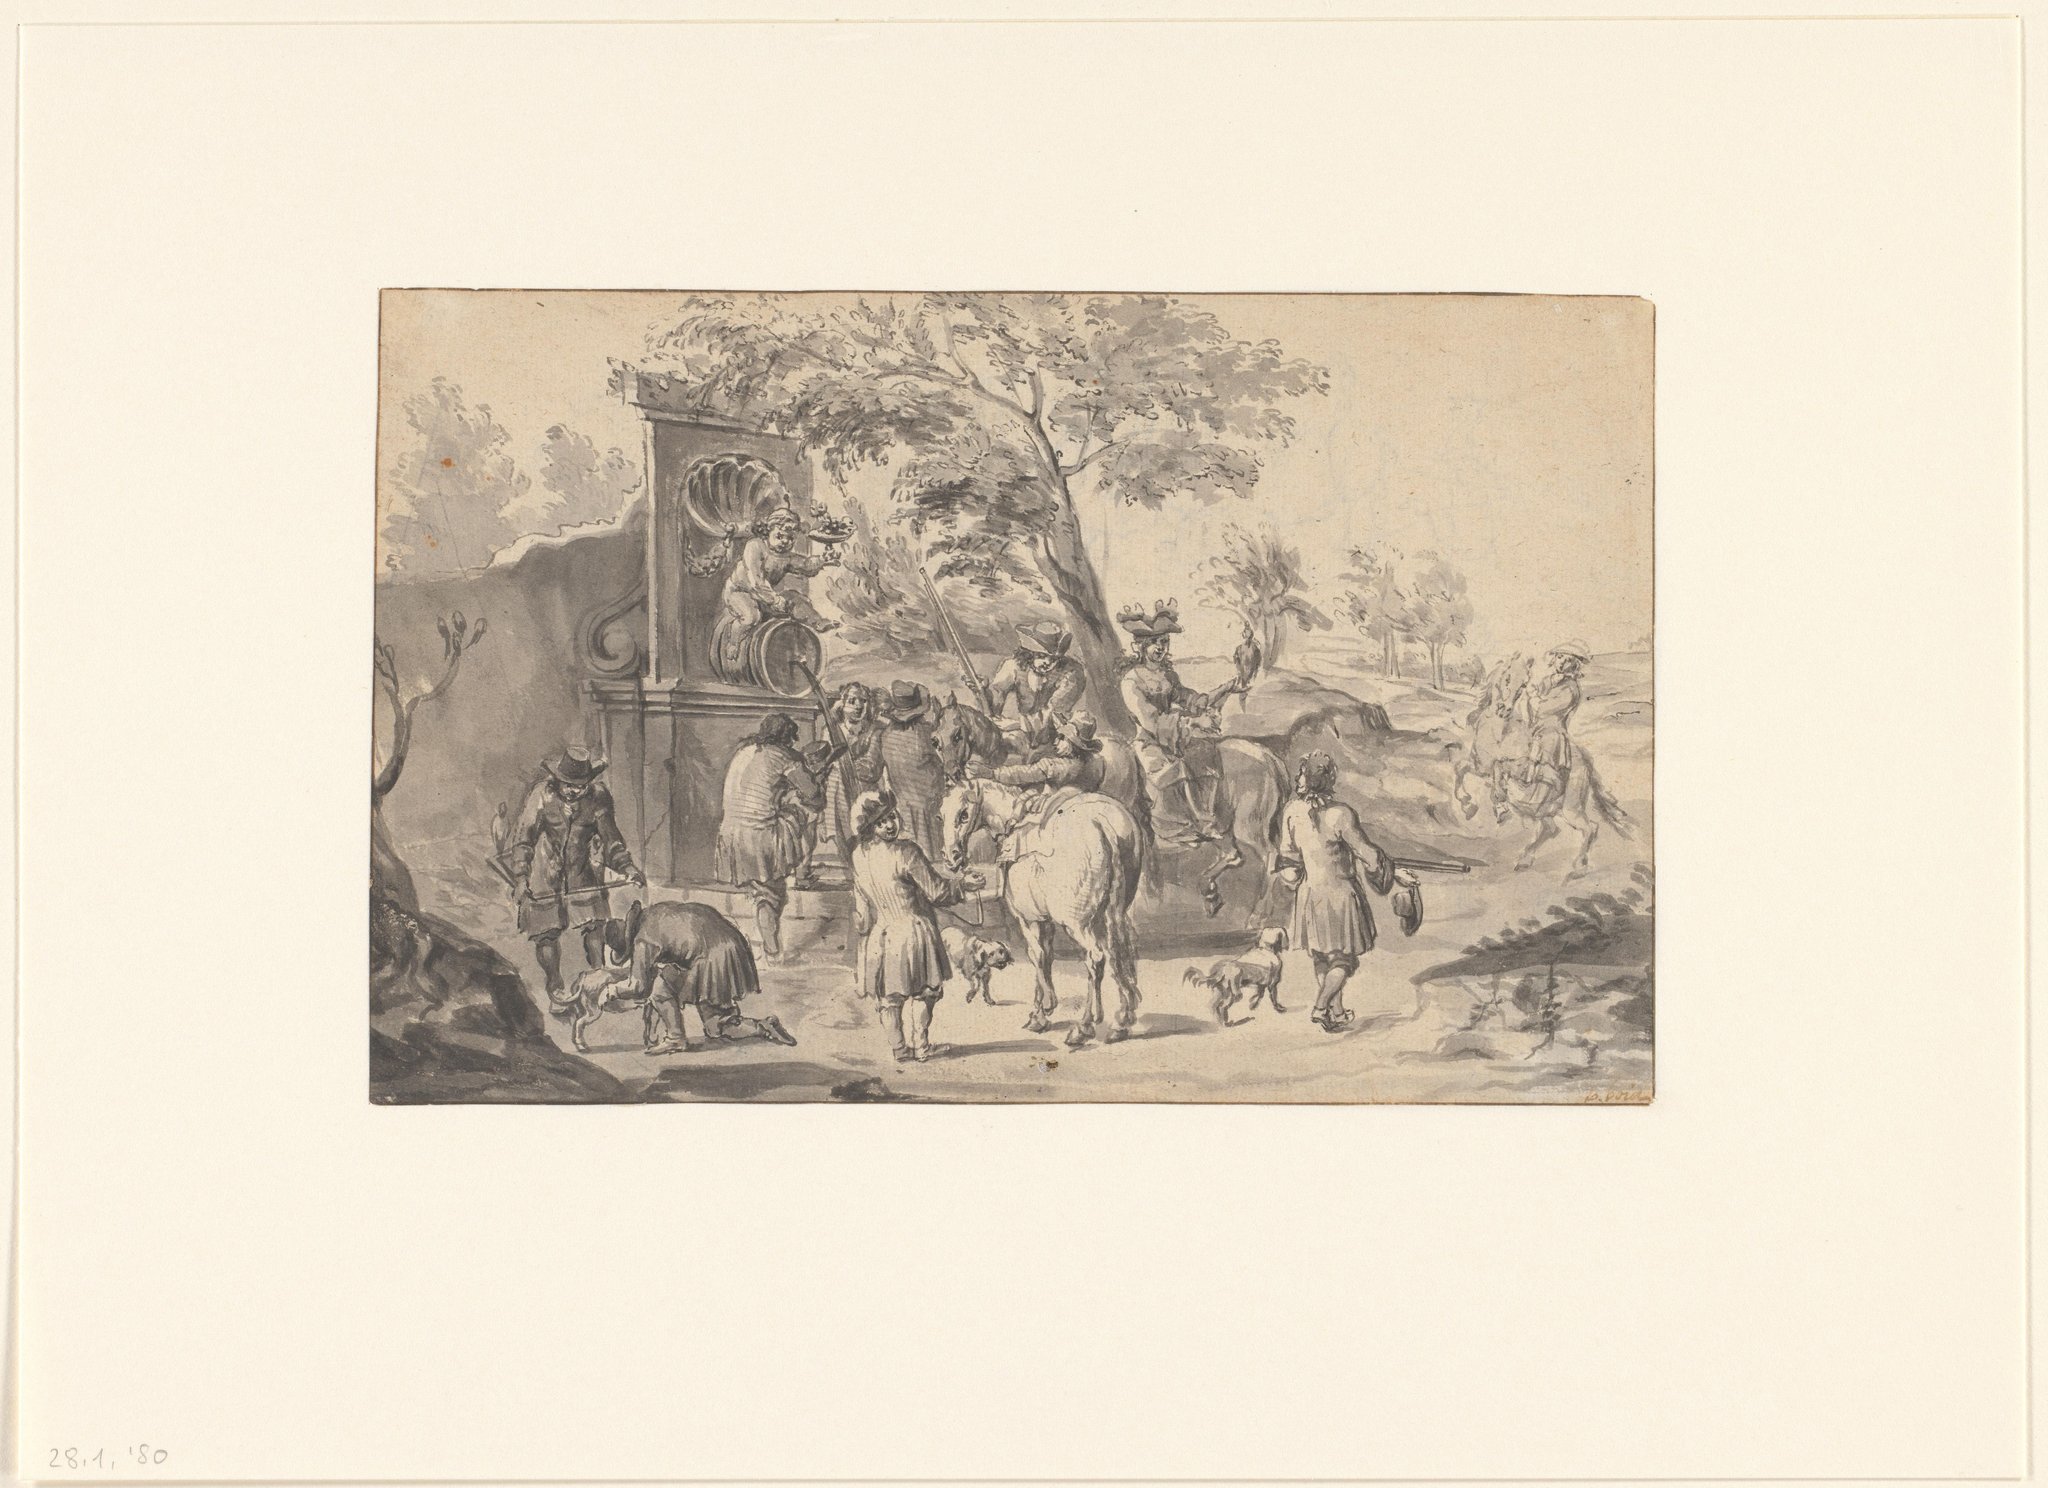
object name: drawing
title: Rust op de valkenjacht, bij een Bacchus-bron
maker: pieter bout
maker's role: draughtsman, print maker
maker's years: 1658-1719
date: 1668-1719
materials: ink, paper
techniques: brush, pen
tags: hunting, chase (+ hunting with falcon, hawk; falconry)